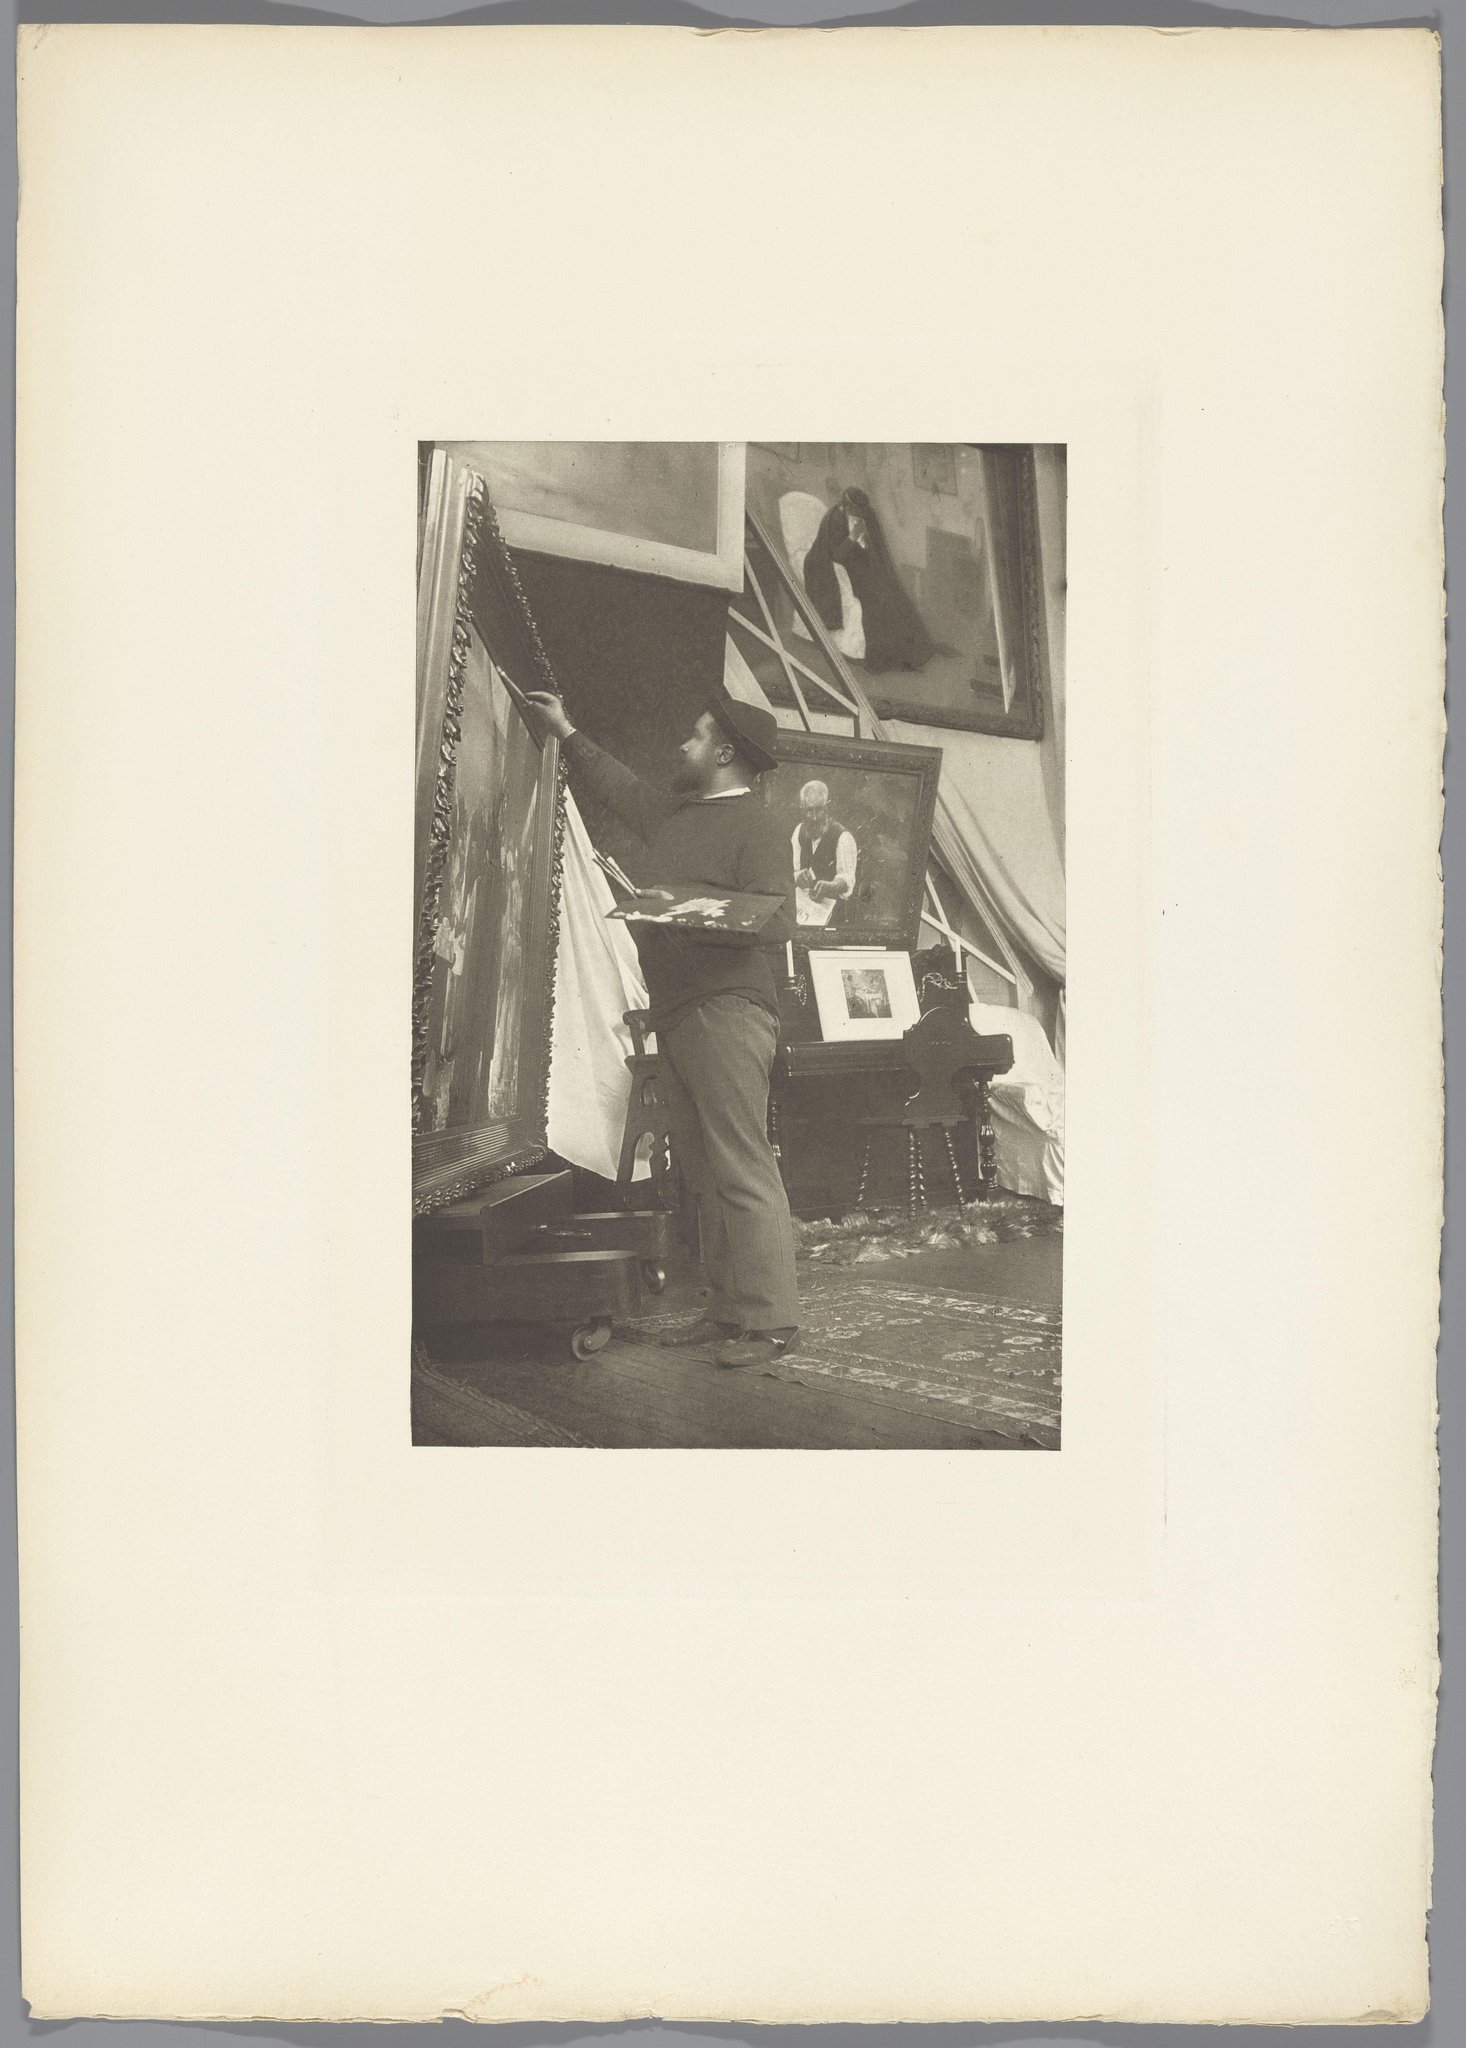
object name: photomechanical print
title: Portret van schilder Jean Jacques Rousseau, aan het werk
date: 1891-1896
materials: paper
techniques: photoaquatint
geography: paris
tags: portrait, self-portrait of painter, painter at work, in his studio, historical persons not known by name